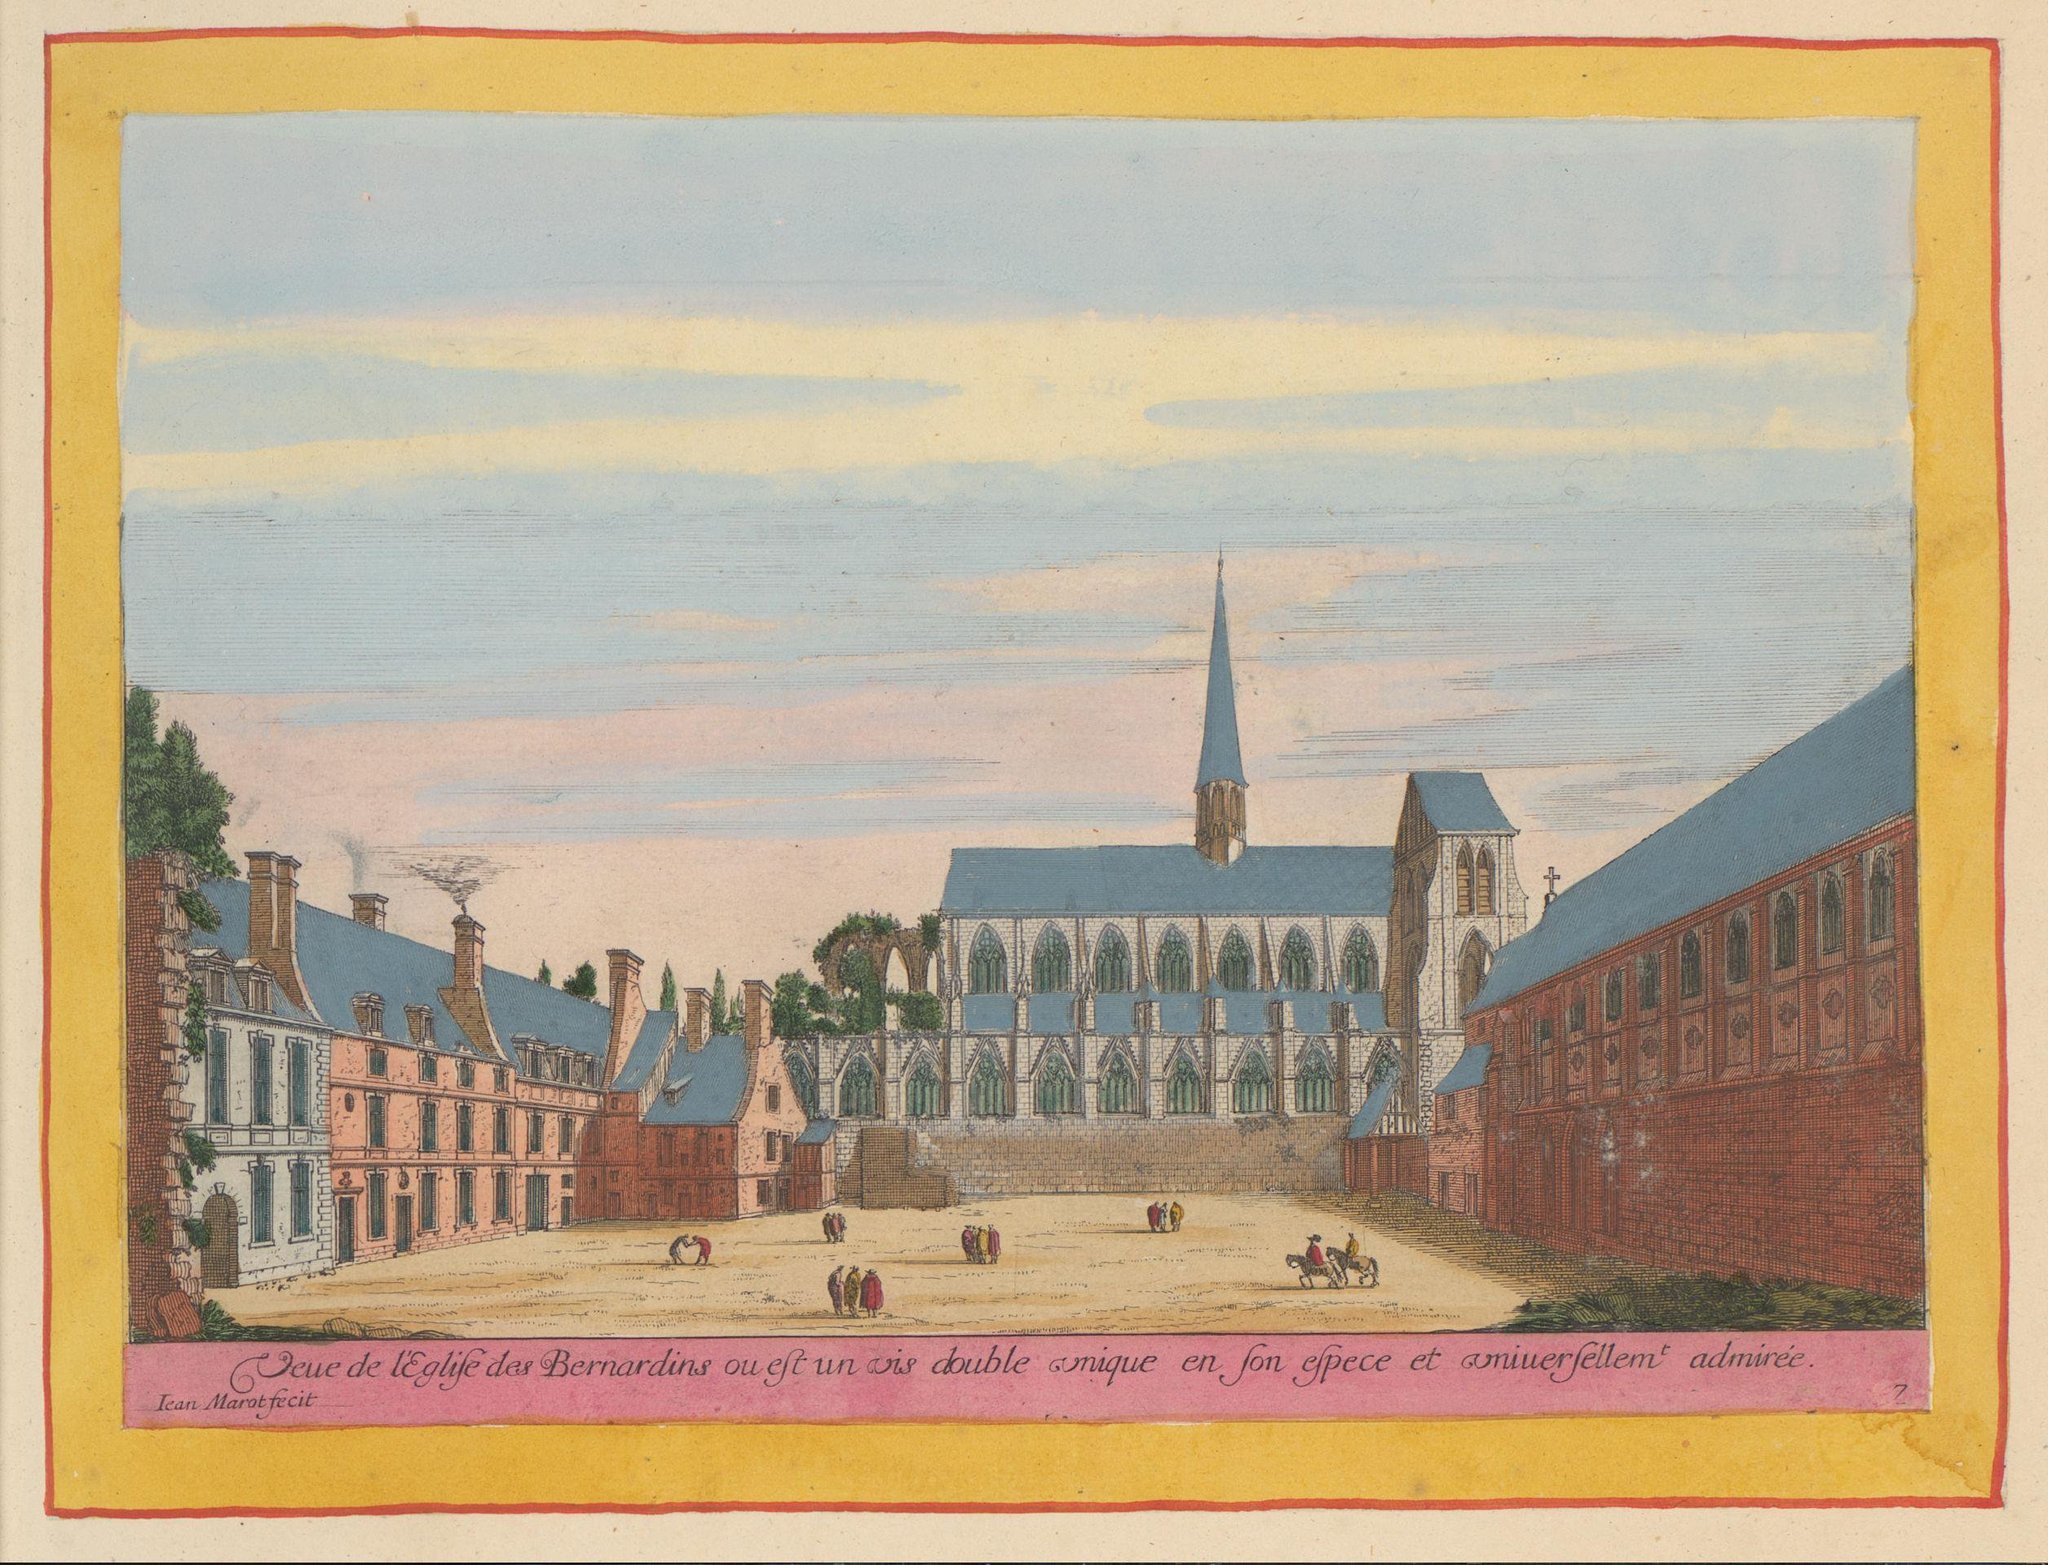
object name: print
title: Veue de l'Eglise des Bernardins ou est un vis double unique en son espece et universellem admirée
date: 1655-1679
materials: paper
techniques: etching, hand coloring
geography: paris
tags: church (exterior)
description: Gezicht op kerk bij het Collége des Bernardins te Parijs. In het college studeerden en woonden Cisterciënzer monniken die aan de Universiteit van Parijs studeerden. Prent maakt deel uit van een album.